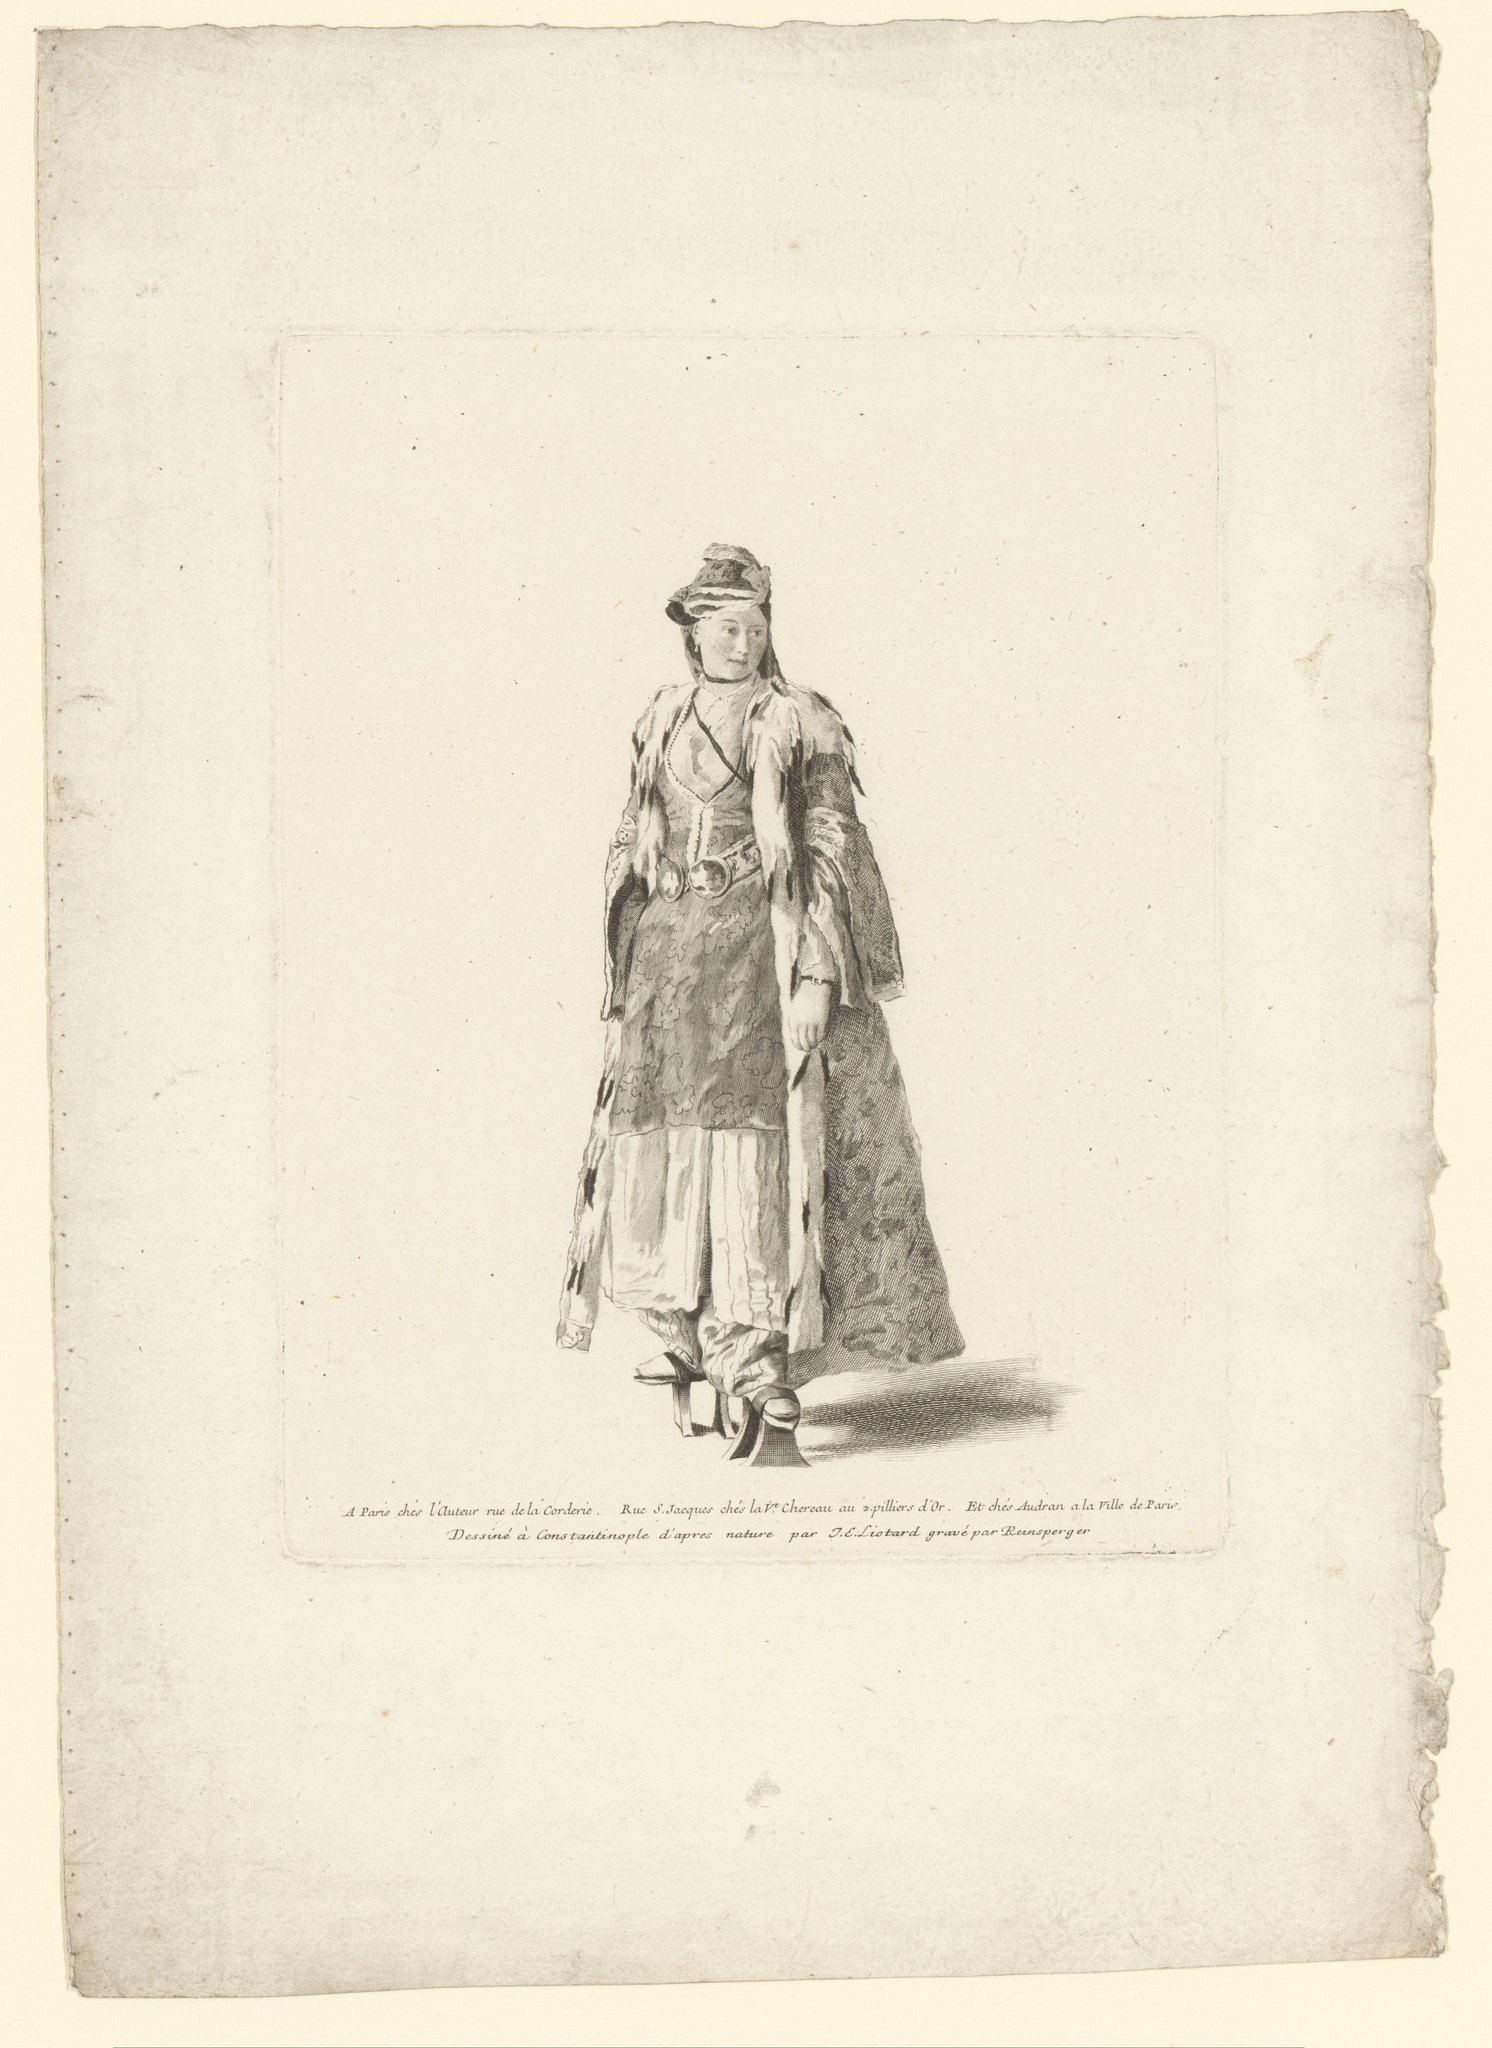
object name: print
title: Vrouw in Turkse drachten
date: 1722-1777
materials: paper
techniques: etching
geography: paris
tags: fashion, clothing, adult woman, folk costume, regional costume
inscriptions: collector's mark: Lugt 2228, collector's mark: Lugt 2760